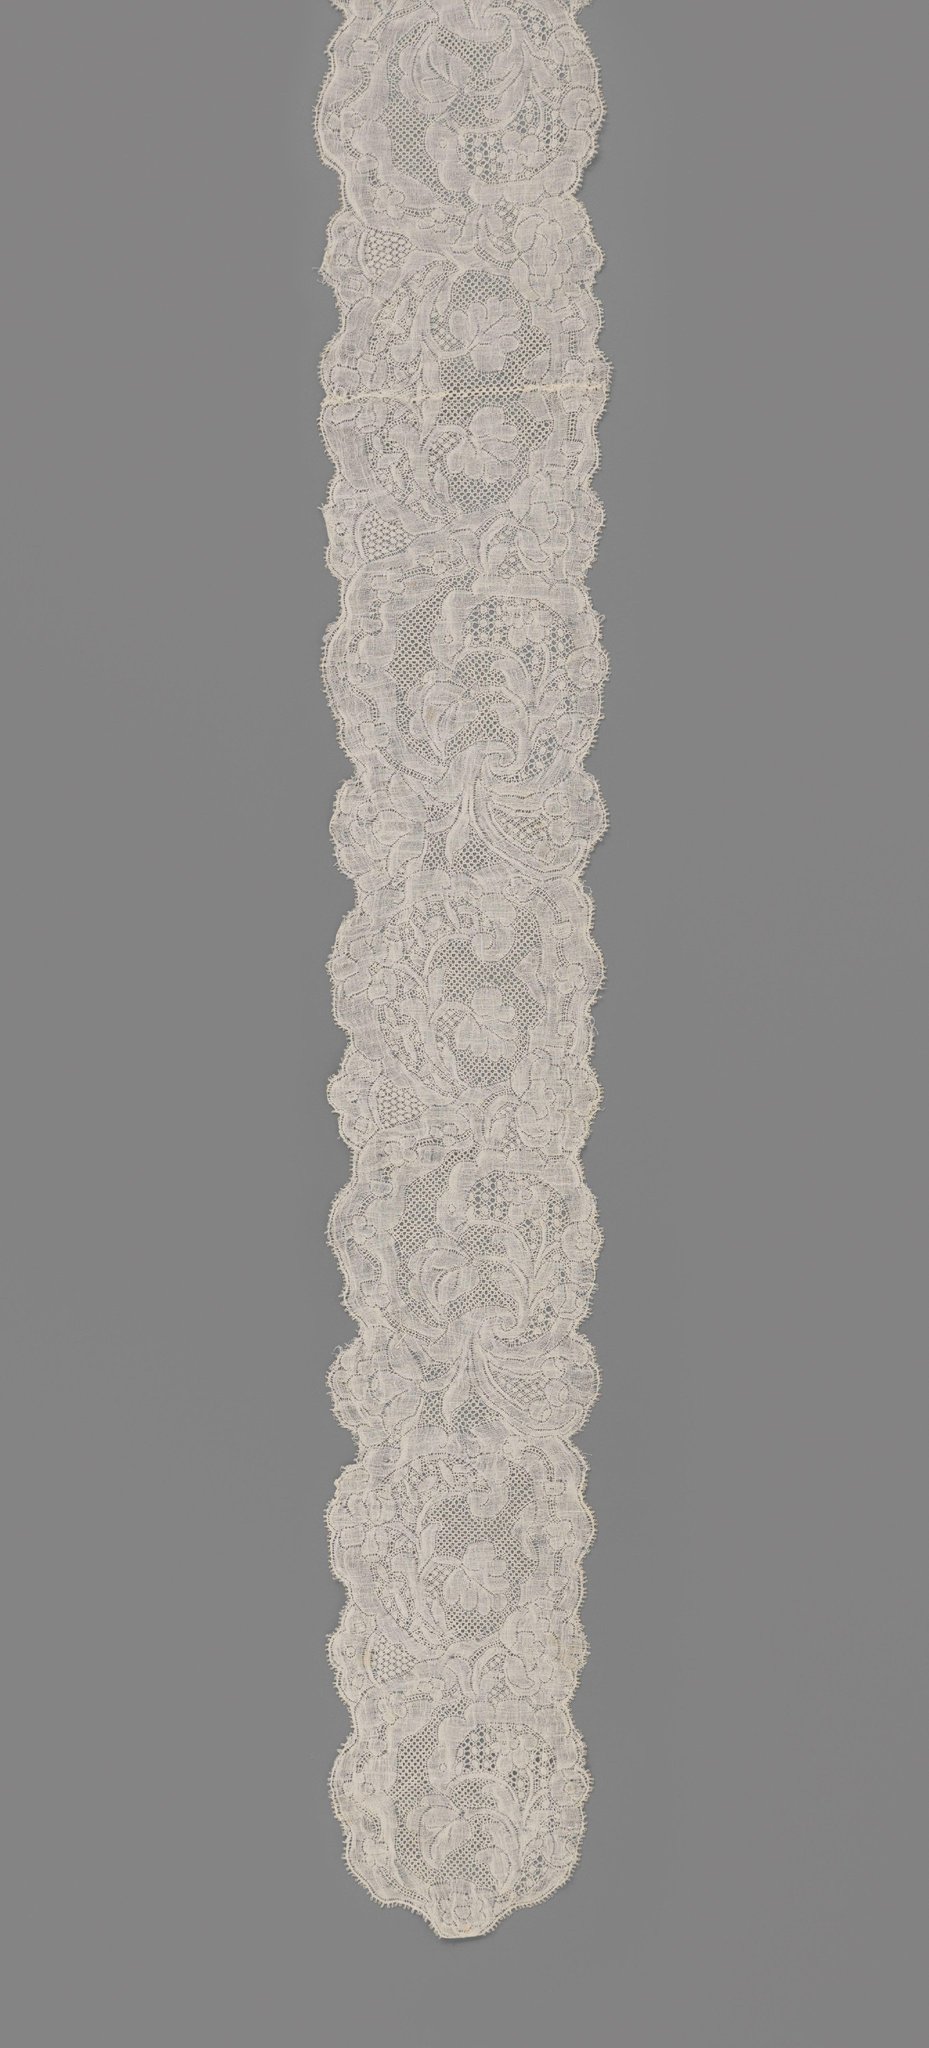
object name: womenswear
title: Mutsenslippen van Binchekant, aaneengenaaid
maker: Anonymous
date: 1750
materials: linen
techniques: lace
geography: southern netherlands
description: Twee aaneengenaaide barbes van kloskant. Het patroon heeft een brede riviere met een aan een rank geregen vierblad, drieblad en een moesje die telkens twee opgaande C-voluten omsluiten. De ruimte binnen de voluten is gevuld met een bloemtak en een handvormig blad op een fond van afwisselend moesjes en vliegjes.